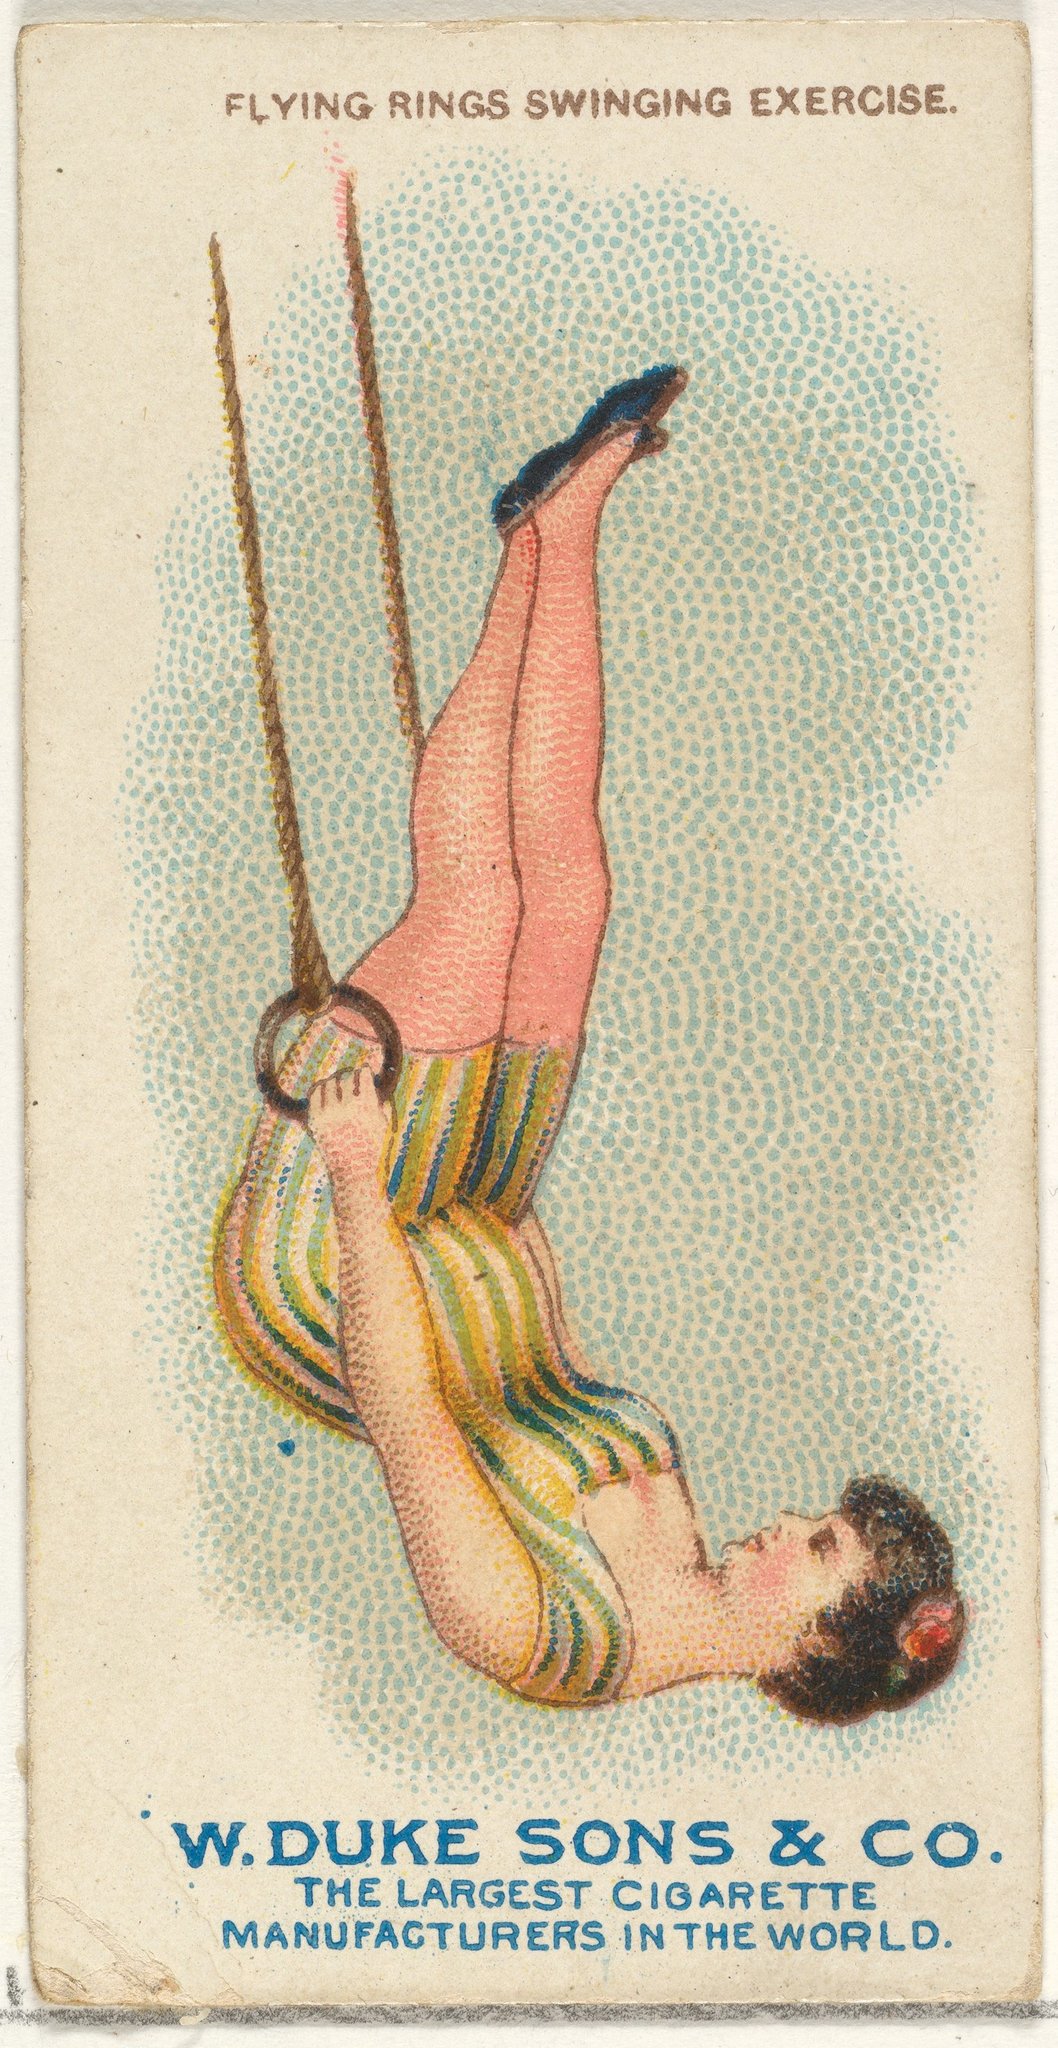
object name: print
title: Flying Rings Swinging Exercise, from the Gymnastic Exercises series (N77) for Duke brand cigarettes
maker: w. duke, sons & co.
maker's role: publisher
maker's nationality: american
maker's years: 1870-1920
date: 1887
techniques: color lithograph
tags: women,athletes